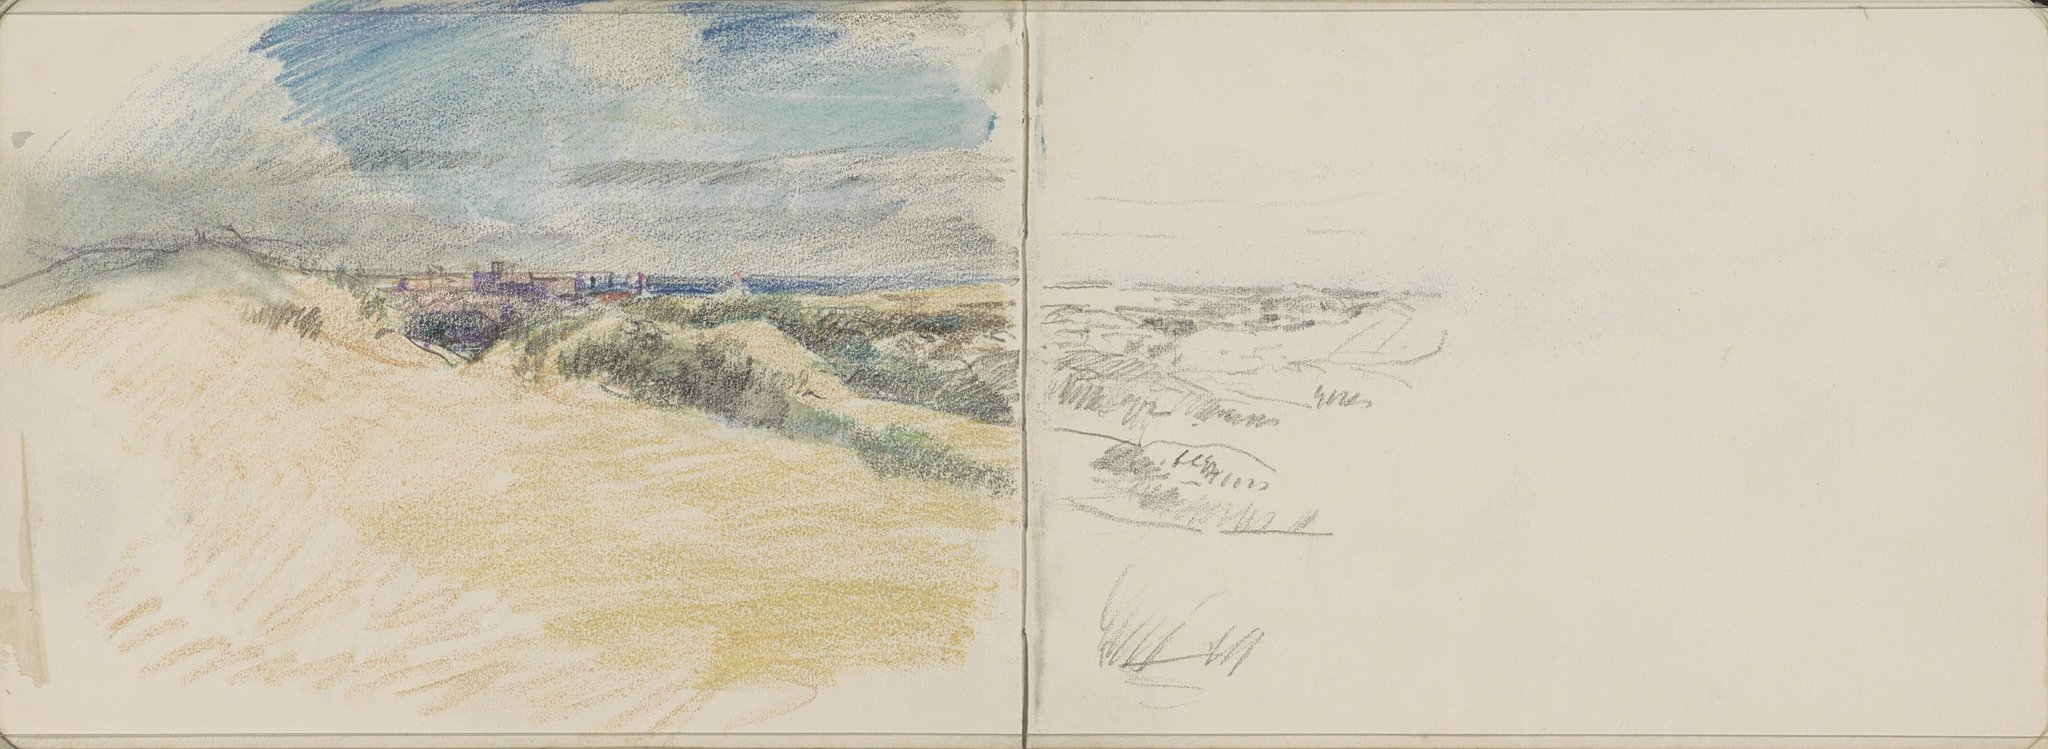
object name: sketchbook leaf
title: Duinlandschap met bebouwing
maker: johan antonie de jonge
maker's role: draughtsman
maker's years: 1864-1927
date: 1881-1927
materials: chalk, paper, watercolor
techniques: stumping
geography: south holland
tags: dunes (sea not visible); in the dunes, civic architecture; edifices; dwellings, sea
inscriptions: kleurnotitie, handgeschreven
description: Duinlandschap. In de verte bebouwing en de zee. Blad 17 verso en blad 18 recto uit een schetsboek met 28 bladen.